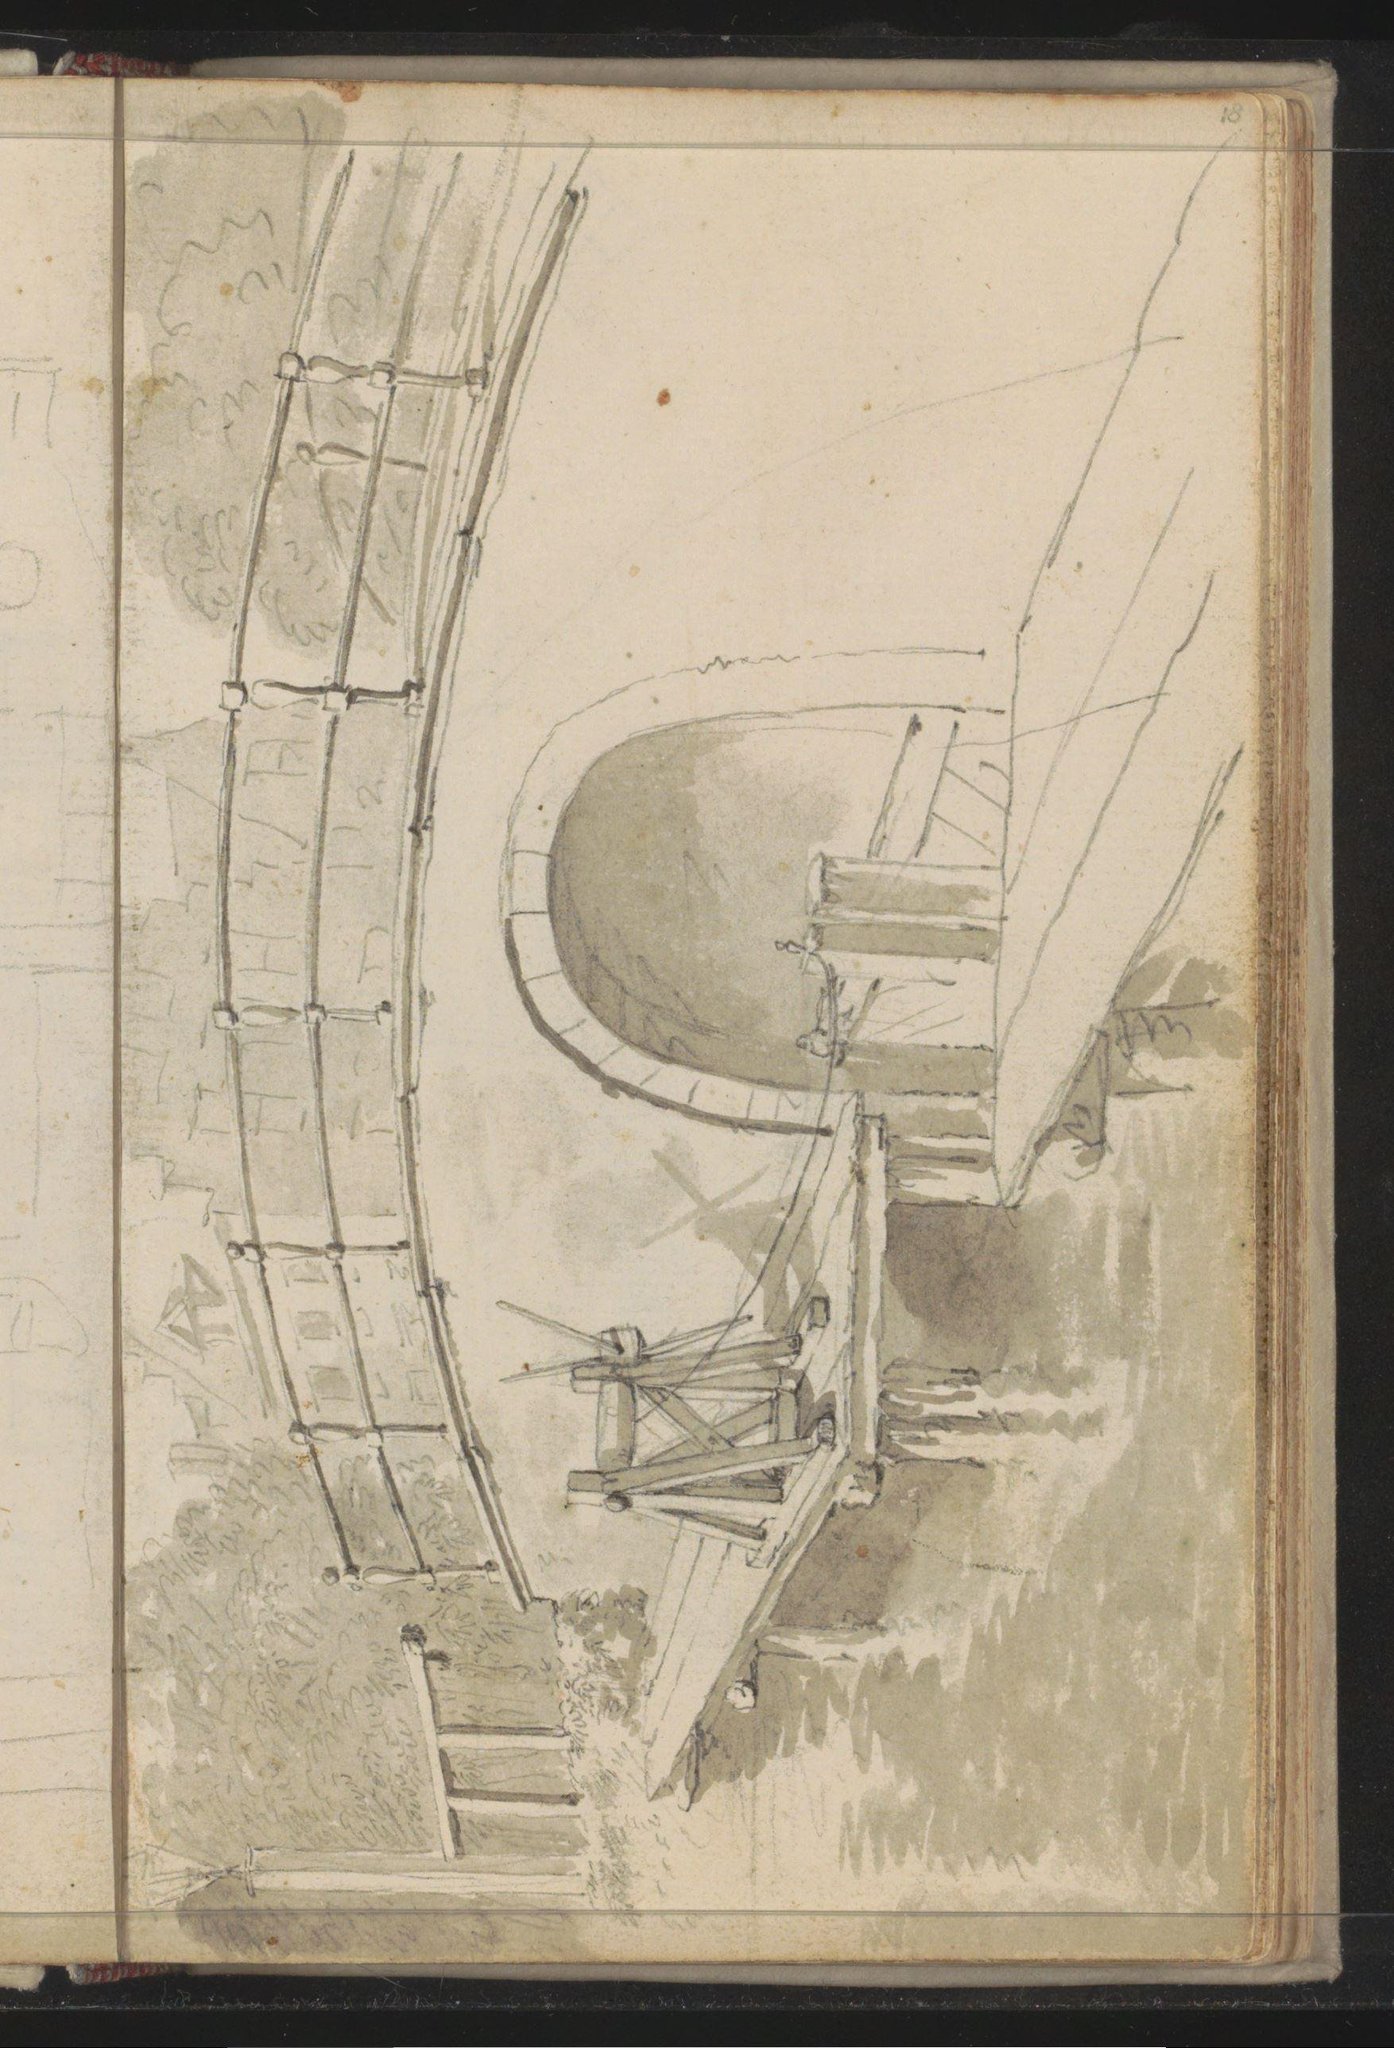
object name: sketchbook leaf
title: Sluis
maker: johannes huibert prins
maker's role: draughtsman, painter, print maker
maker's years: 1757-1806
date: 1783-1797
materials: paper, pencil, watercolor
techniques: brush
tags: lift-lock, canal lock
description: Pagina 18 uit een schetsboek met 175 pagina's.